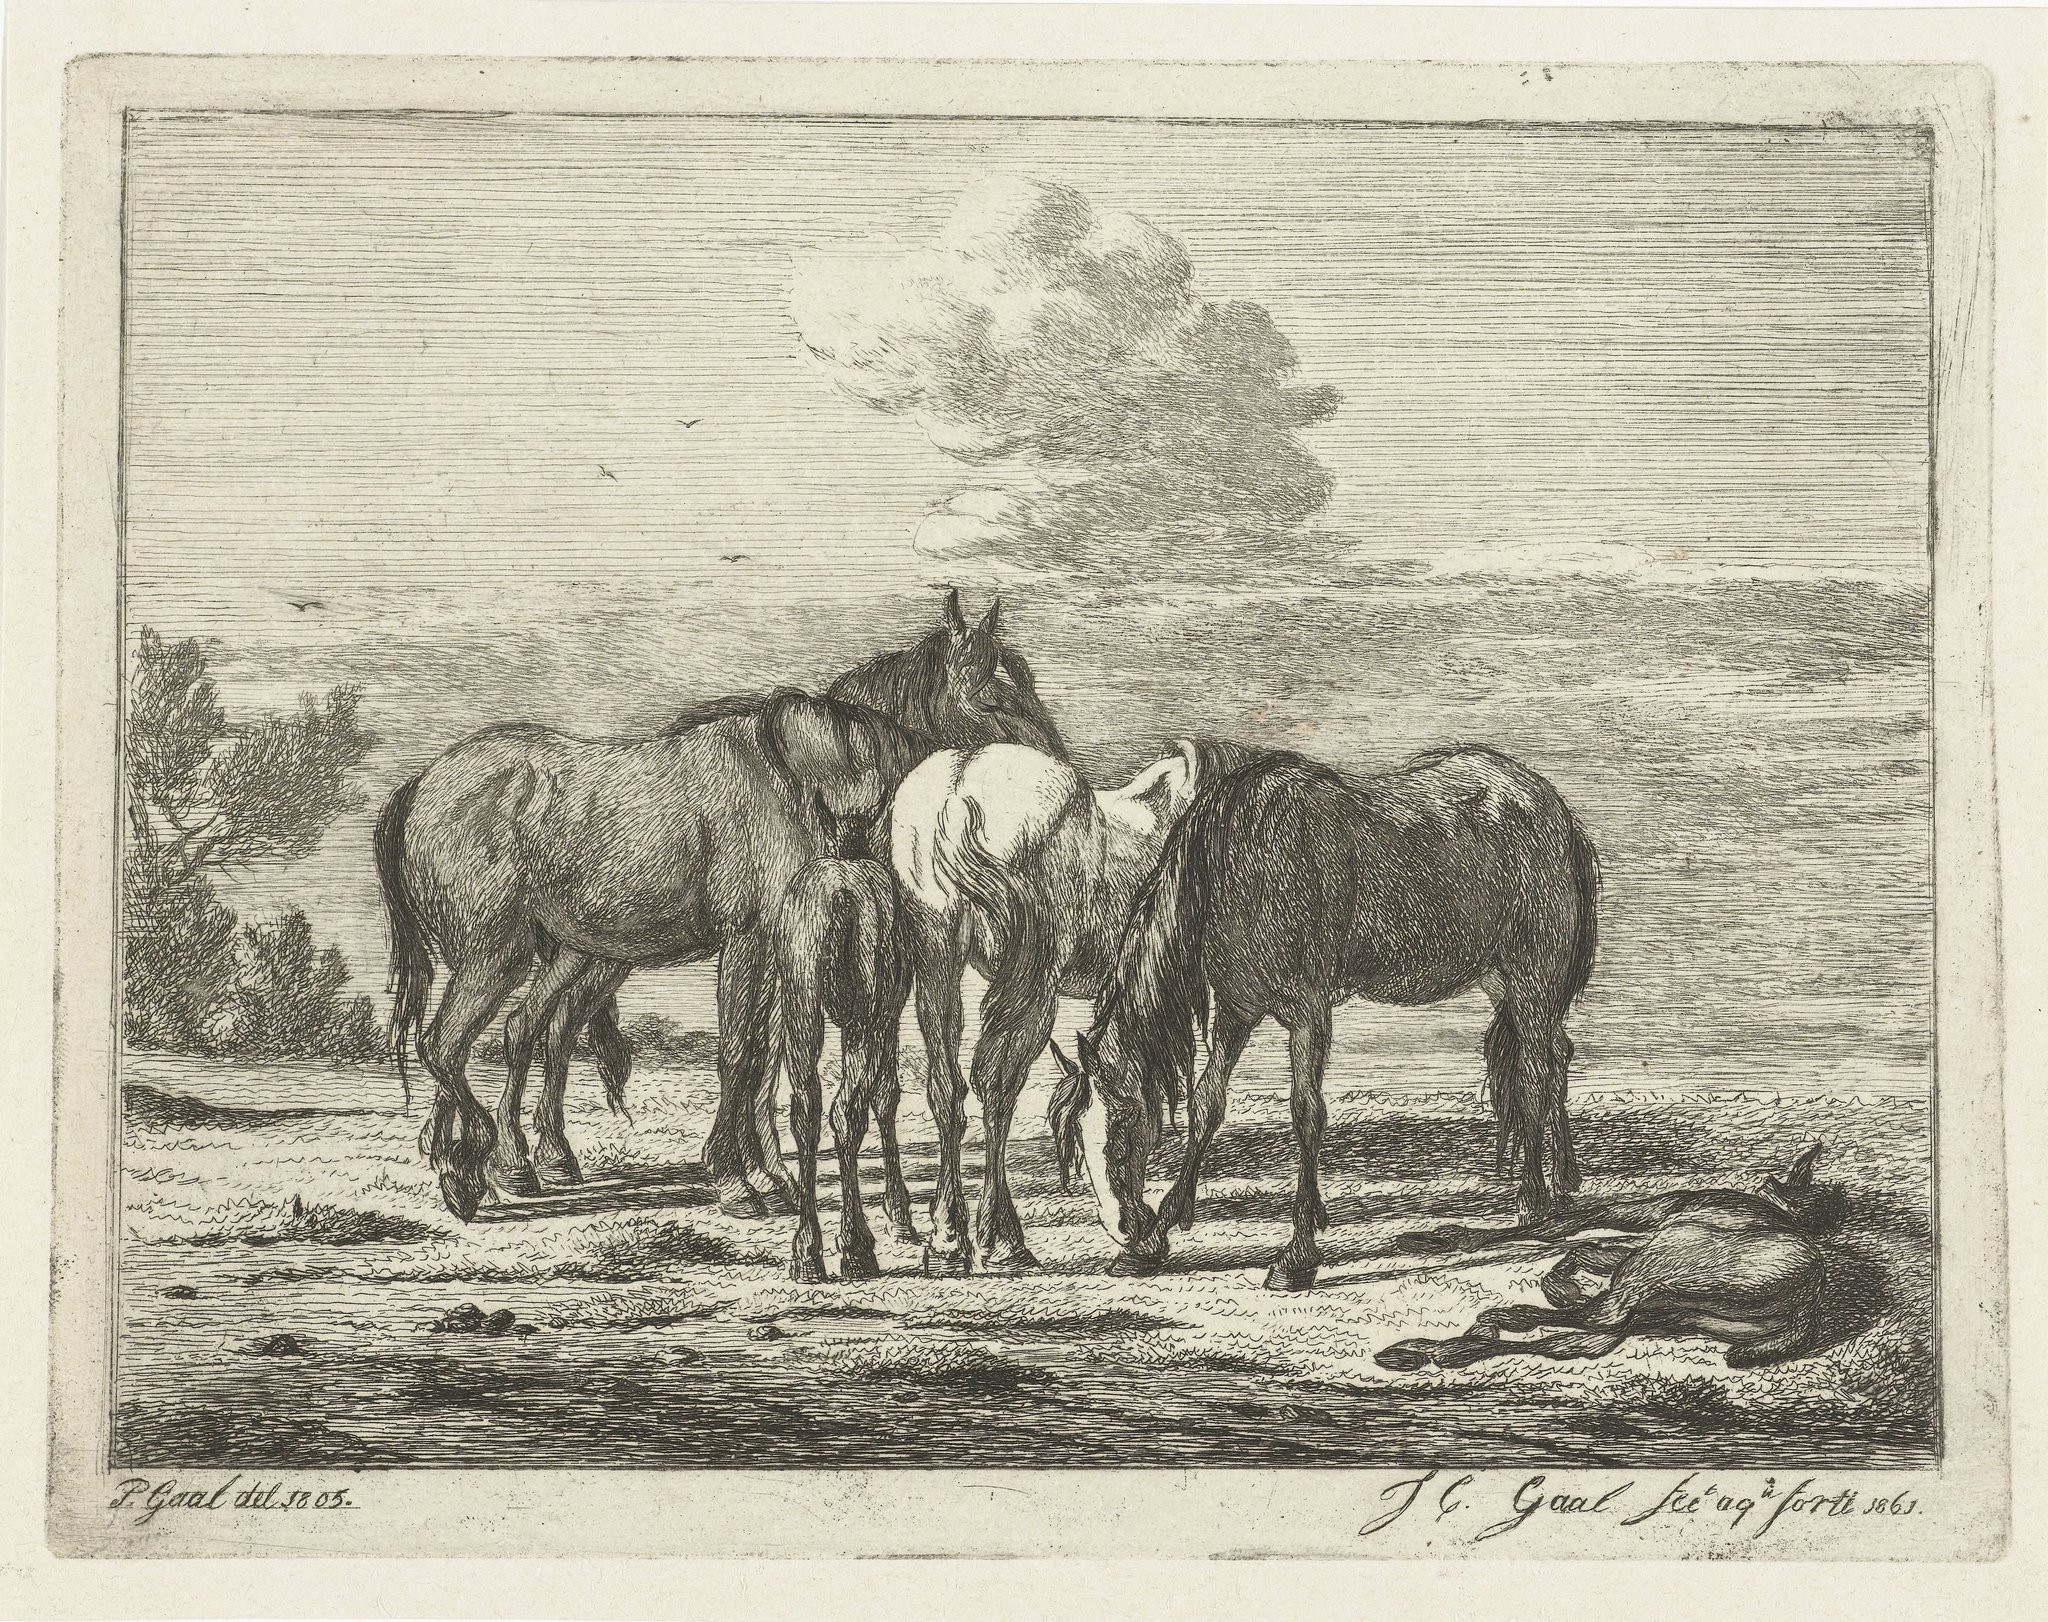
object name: print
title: Vier paarden en de twee veulen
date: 1861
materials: paper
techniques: etching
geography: netherlands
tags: bull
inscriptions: collector's mark: Lugt 2228